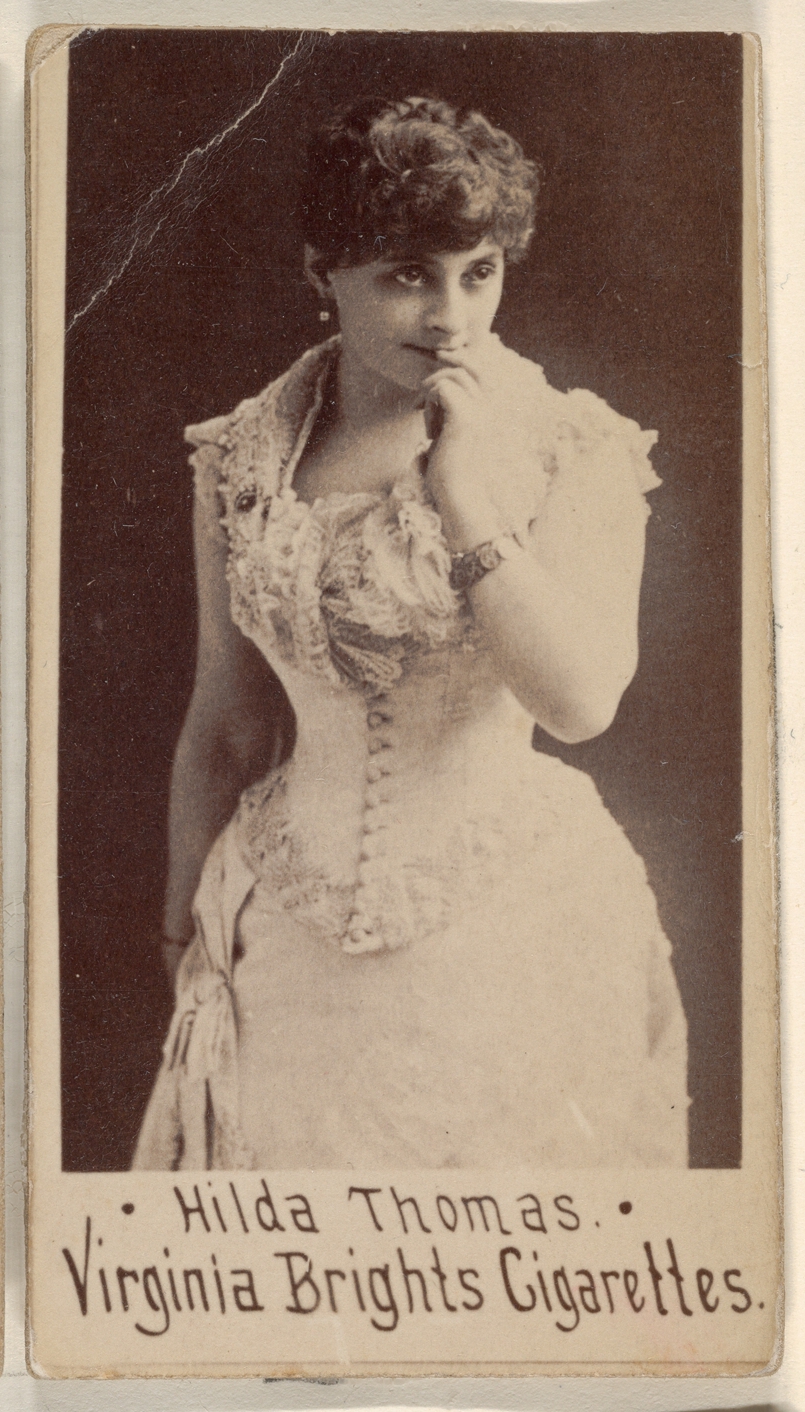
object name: photograph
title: Hilda Thomas, from the Actors and Actresses series (N45, Type 1) for Virginia Brights Cigarettes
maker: allen & ginter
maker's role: publisher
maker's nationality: american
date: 1888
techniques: albumen silver print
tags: portraits,women,actresses